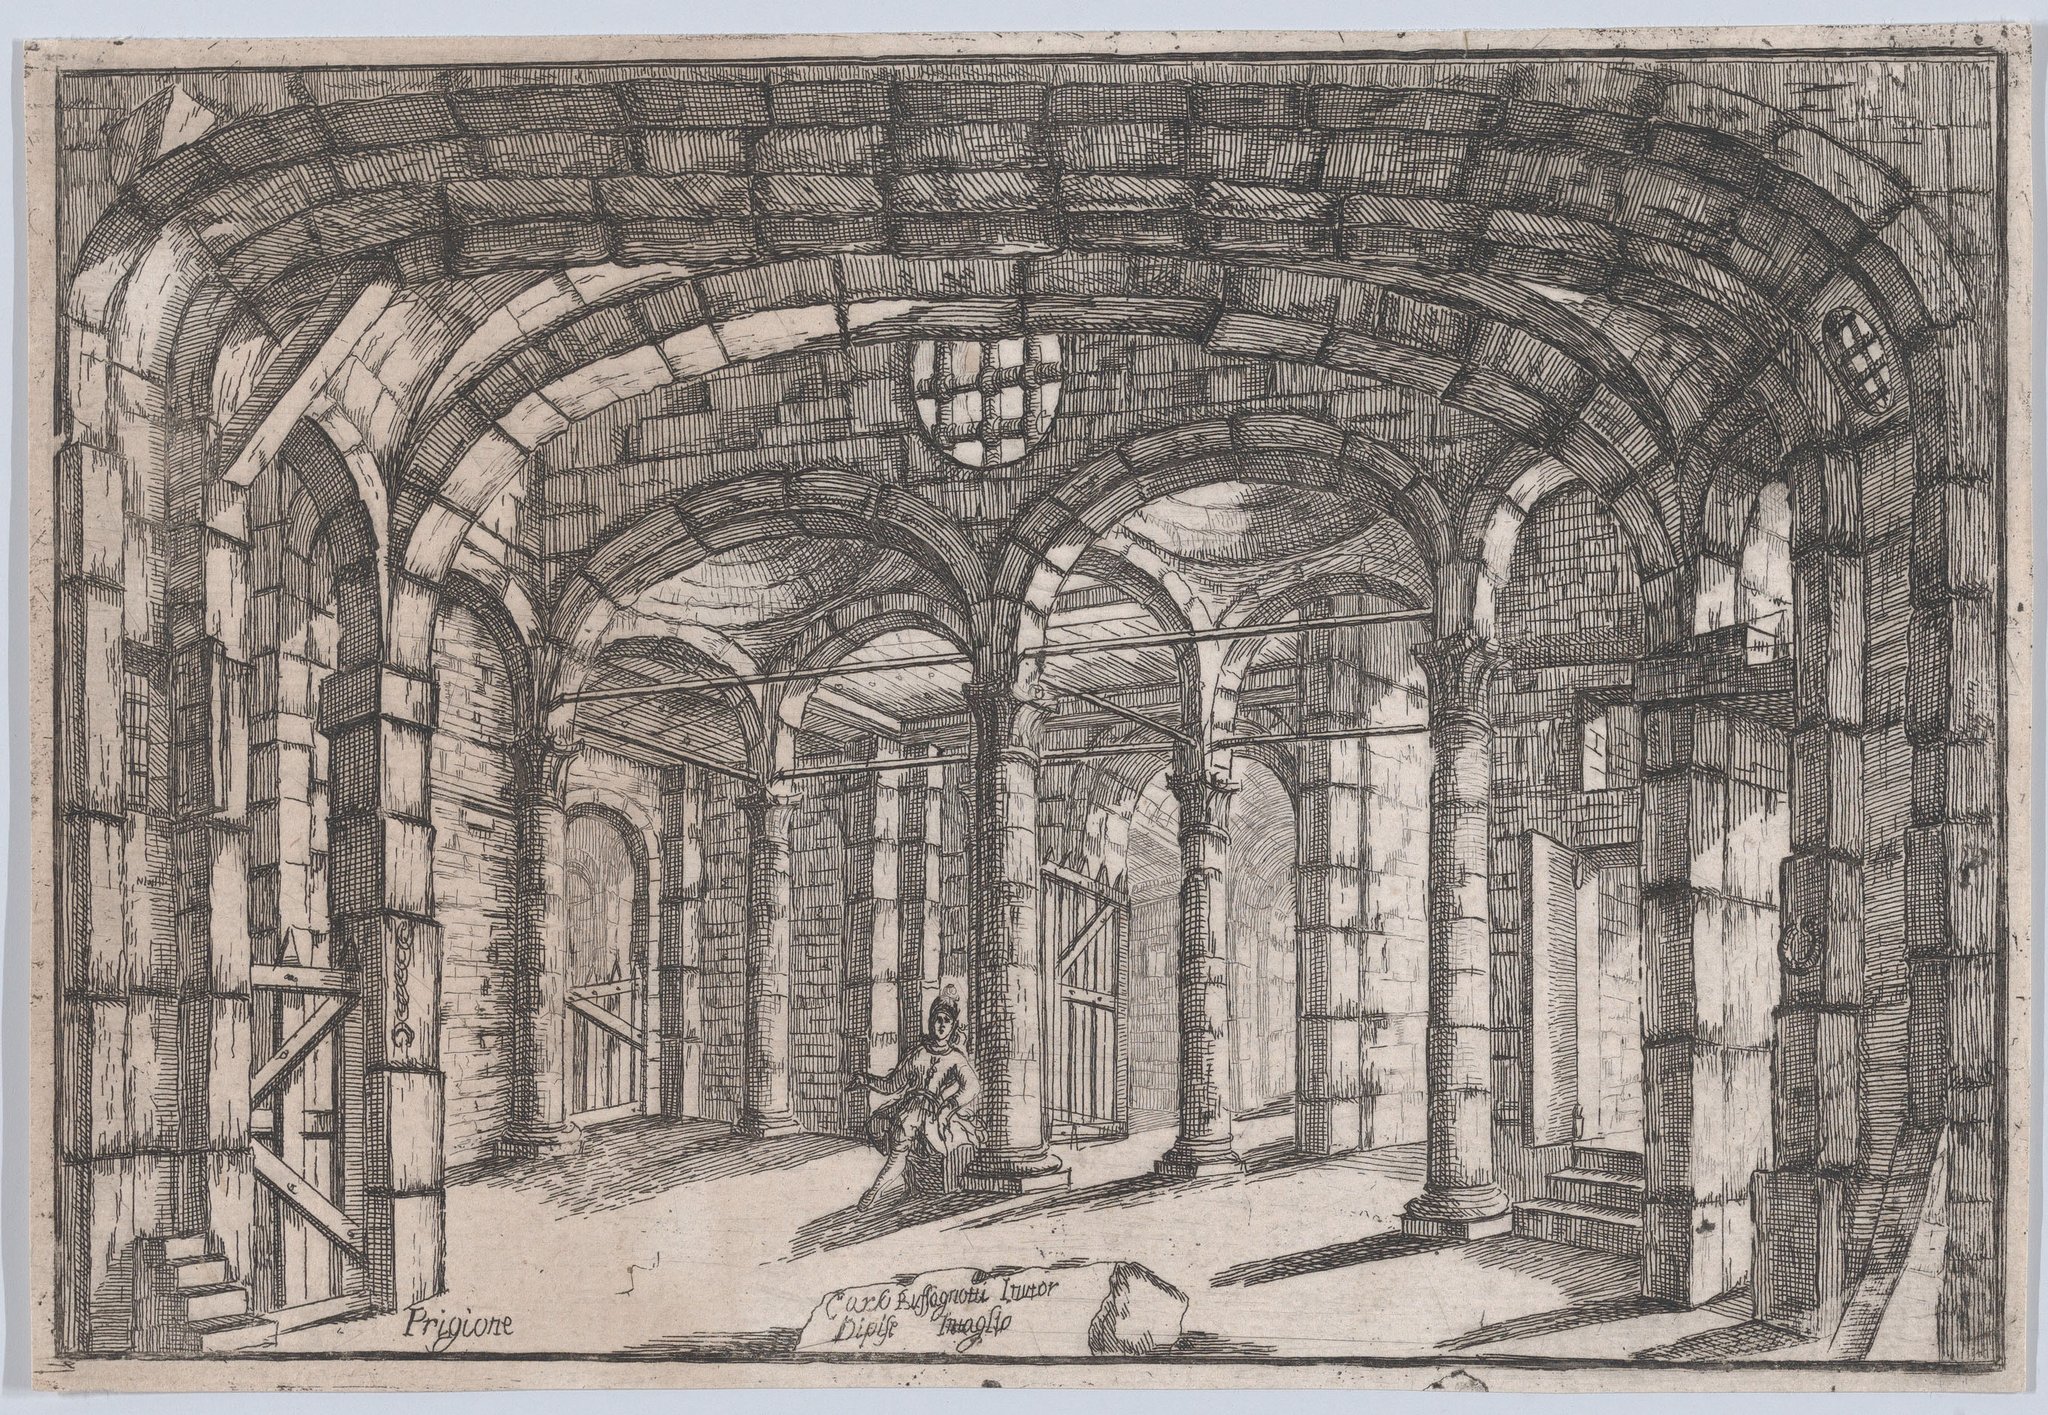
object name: print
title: Interior of a prison in which sits a woman (possibly a theatre set)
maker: carlo antonio buffagnotti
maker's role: artist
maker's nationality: italian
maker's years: 1660-1710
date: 1680-1710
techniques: etching